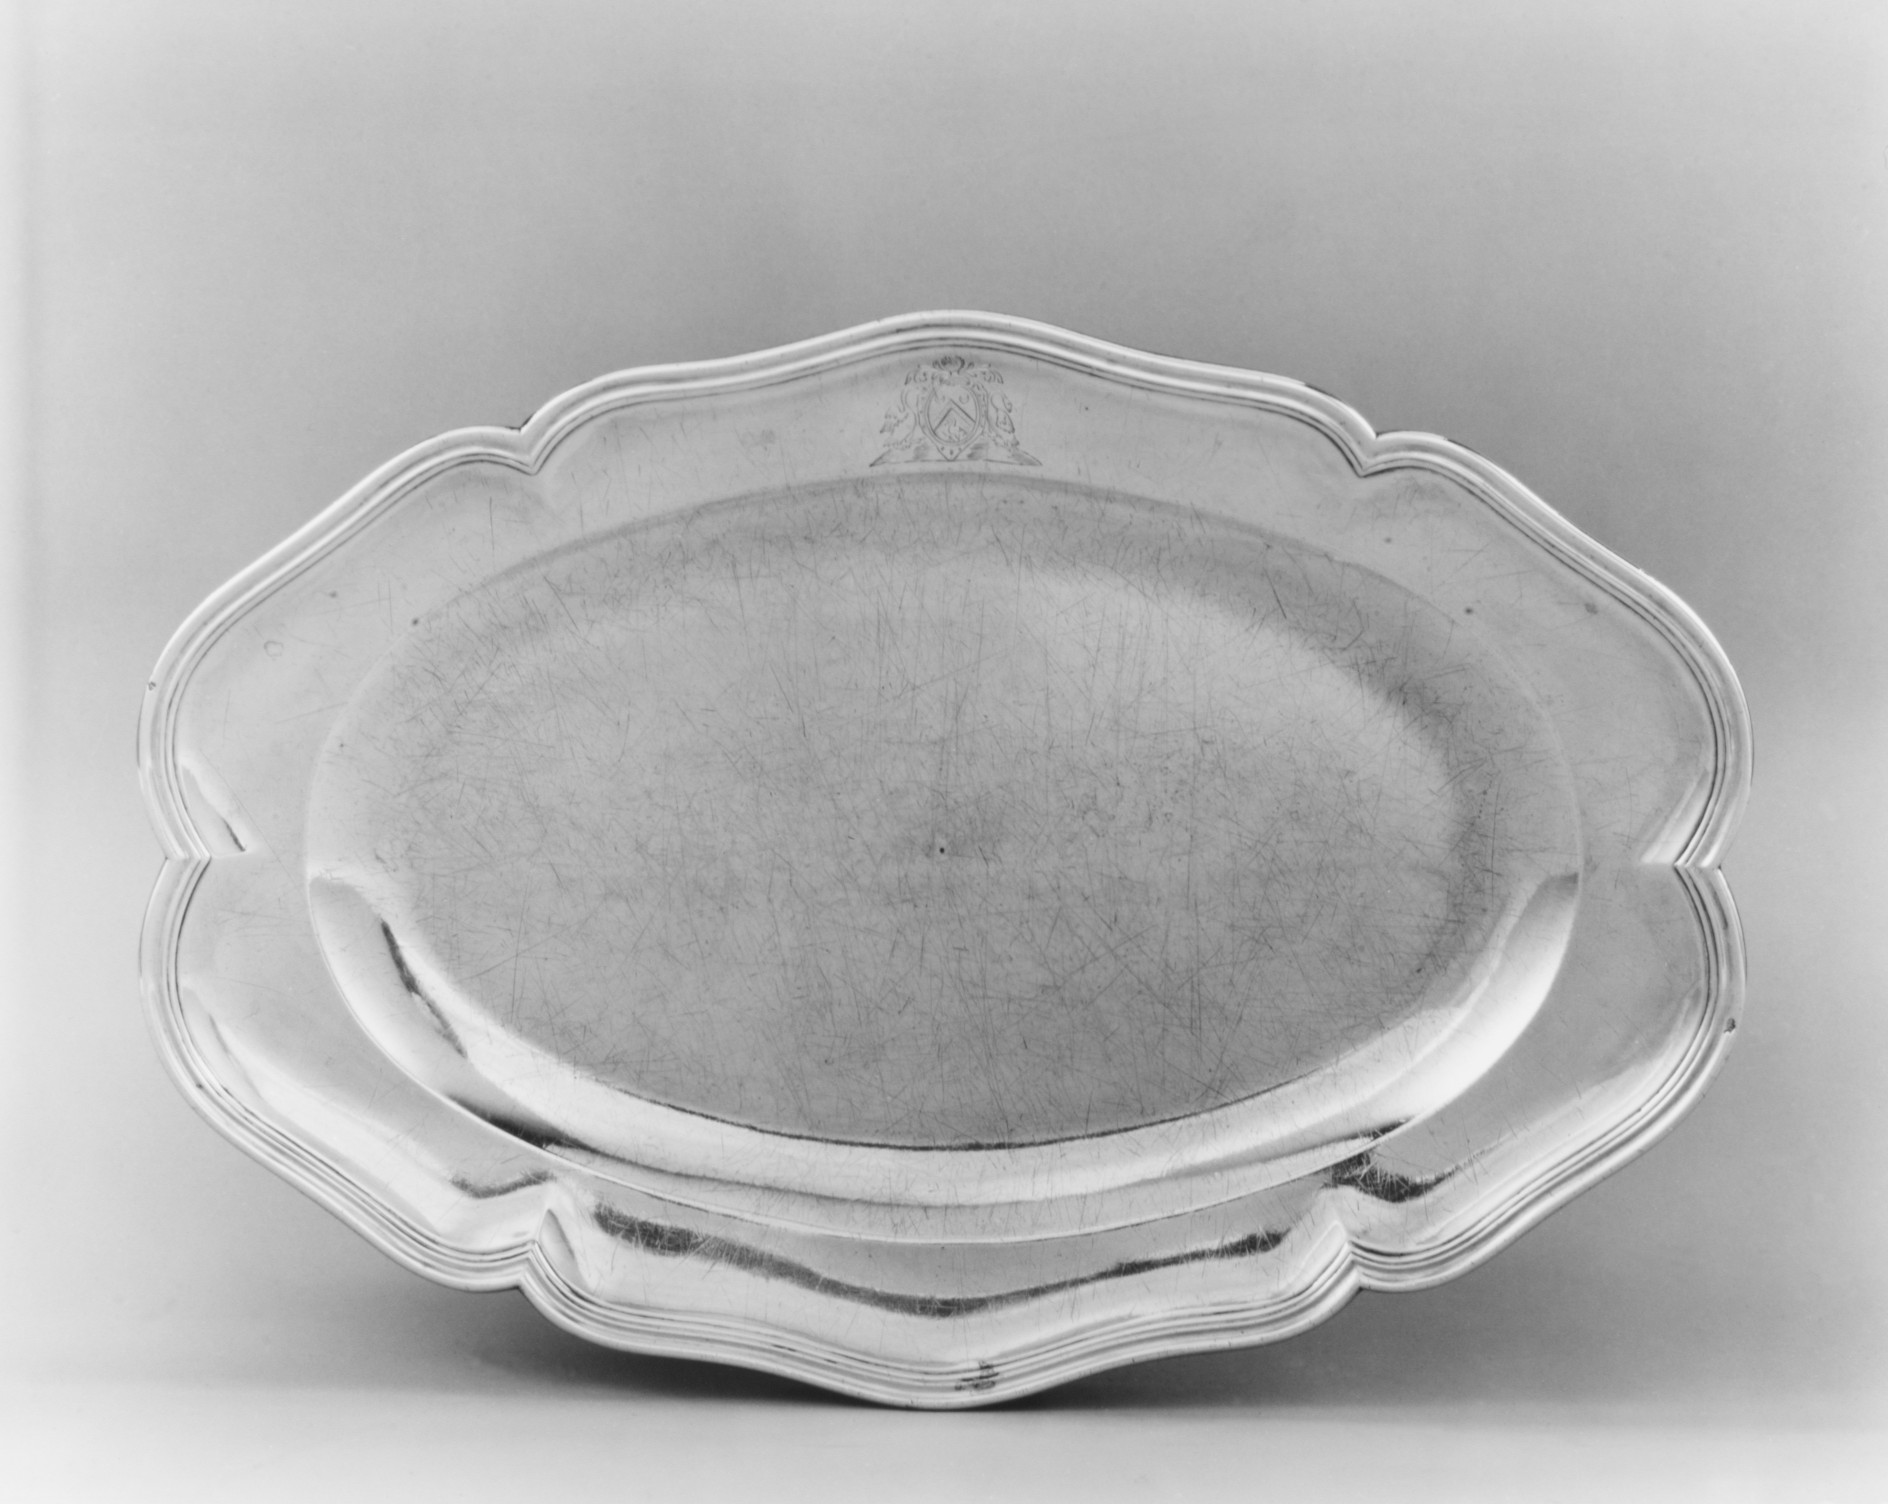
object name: dish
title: Oval dish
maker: jacques-claude pourcelle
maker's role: maker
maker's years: 1713-1773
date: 1768-1775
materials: silver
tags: coat of arms